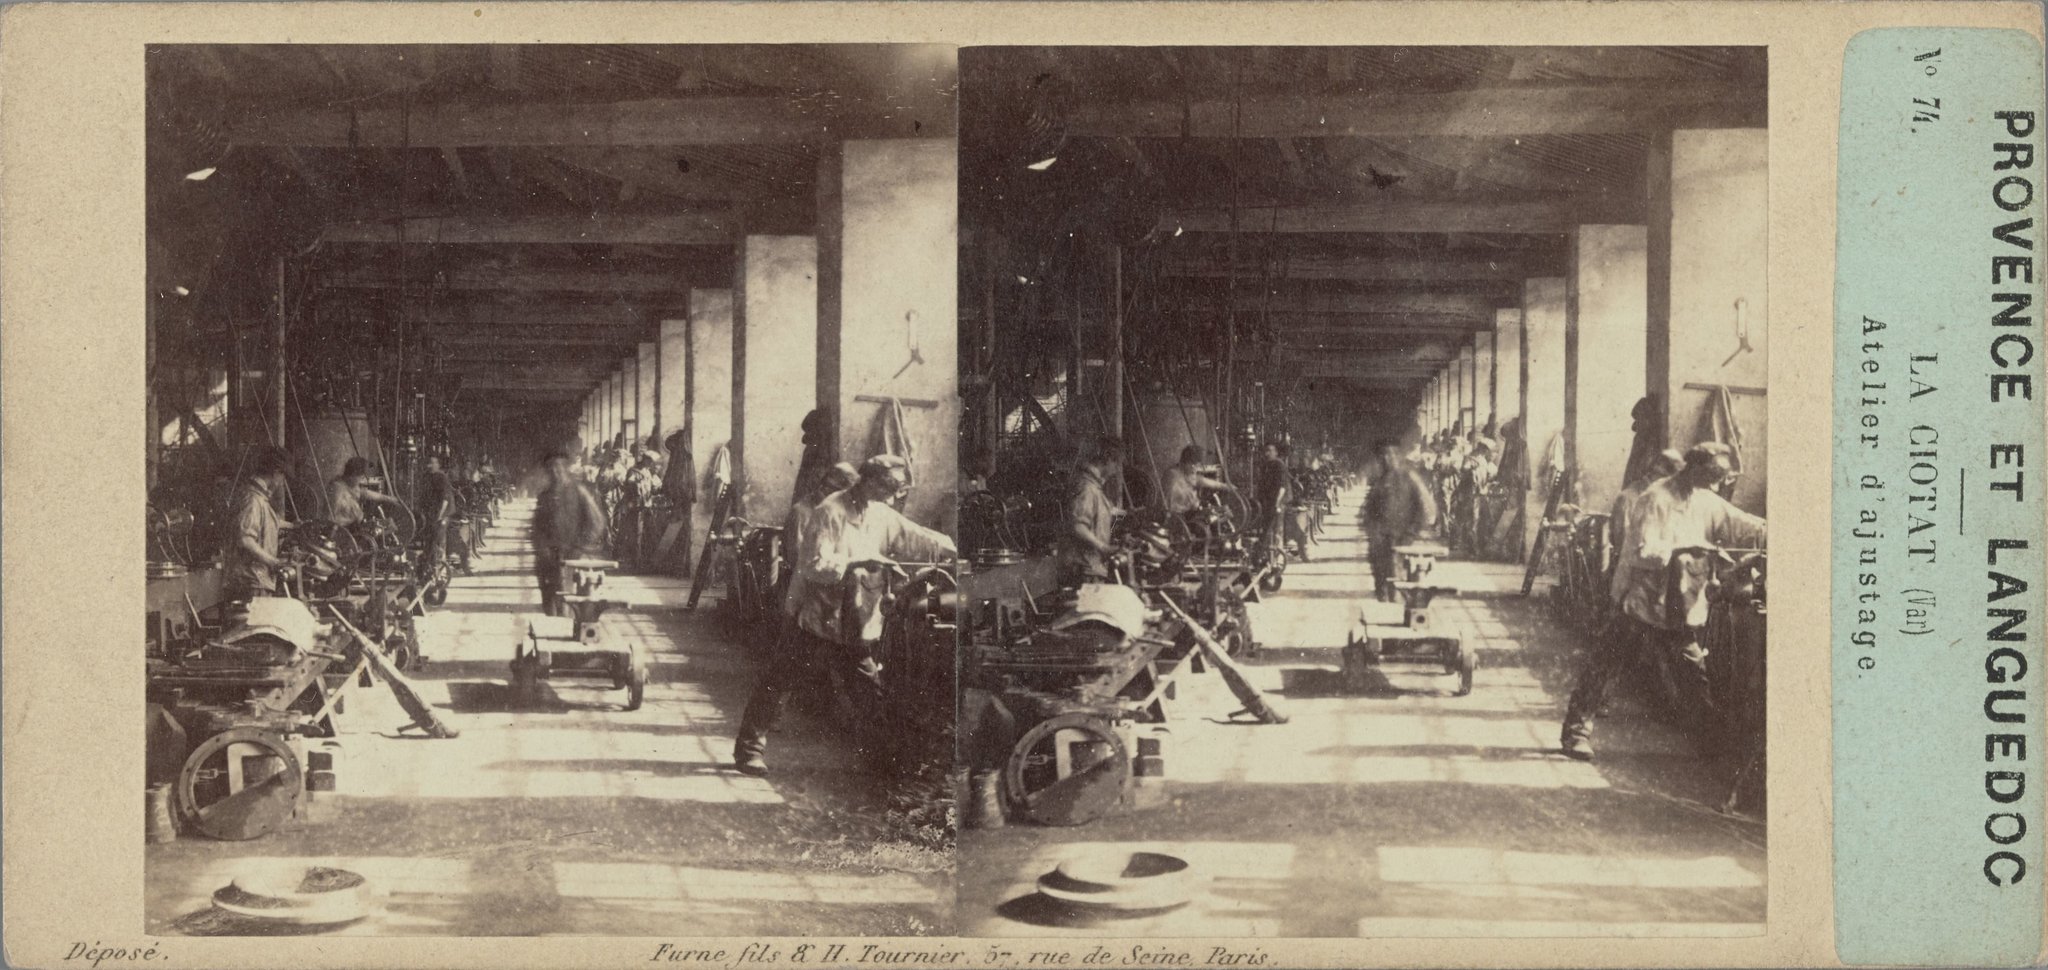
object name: stereograph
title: Provence et Languedoc La Ciotat (Var) Atelier d'ajustage.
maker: Anonymous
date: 1860-1880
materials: cardboard, paper, photographic support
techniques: albumen print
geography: la ciotat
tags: workshop-interior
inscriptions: number: ‘No. 74.’, inscription: ‘Au Jardin des Tuileries 202, rue de Rivoli, B. Guérard (...)’